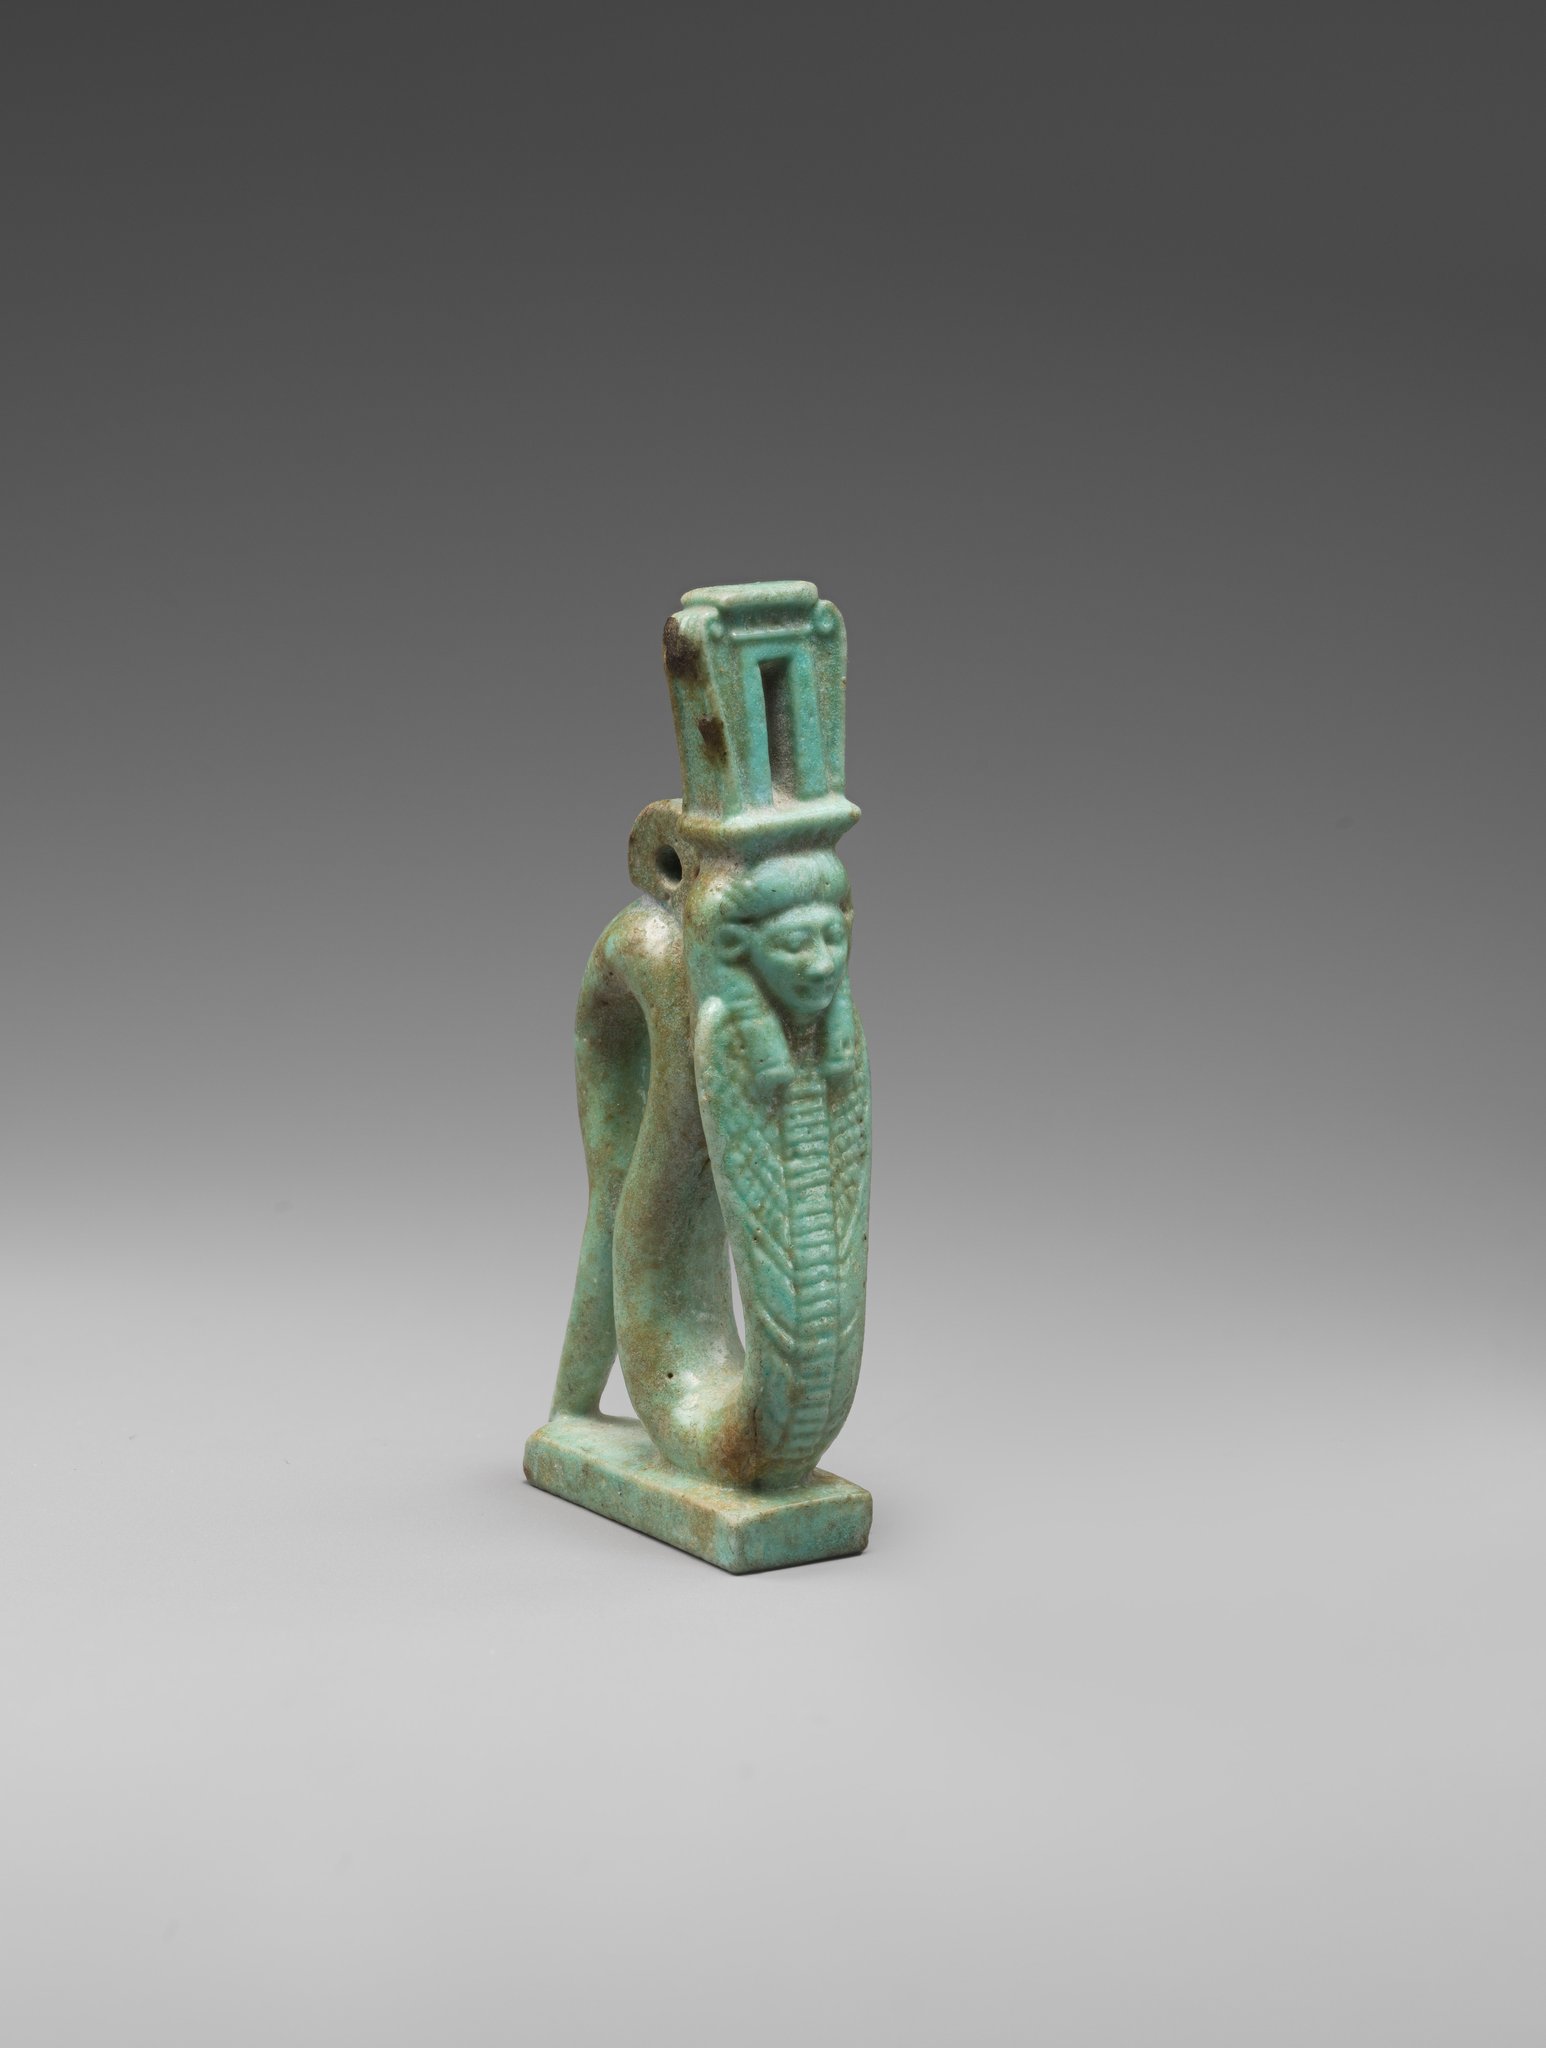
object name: hathor amulet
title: Amulet of a rearing cobra with a Hathor-emblem head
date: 1070-332 BCE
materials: faience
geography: egypt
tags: hathor